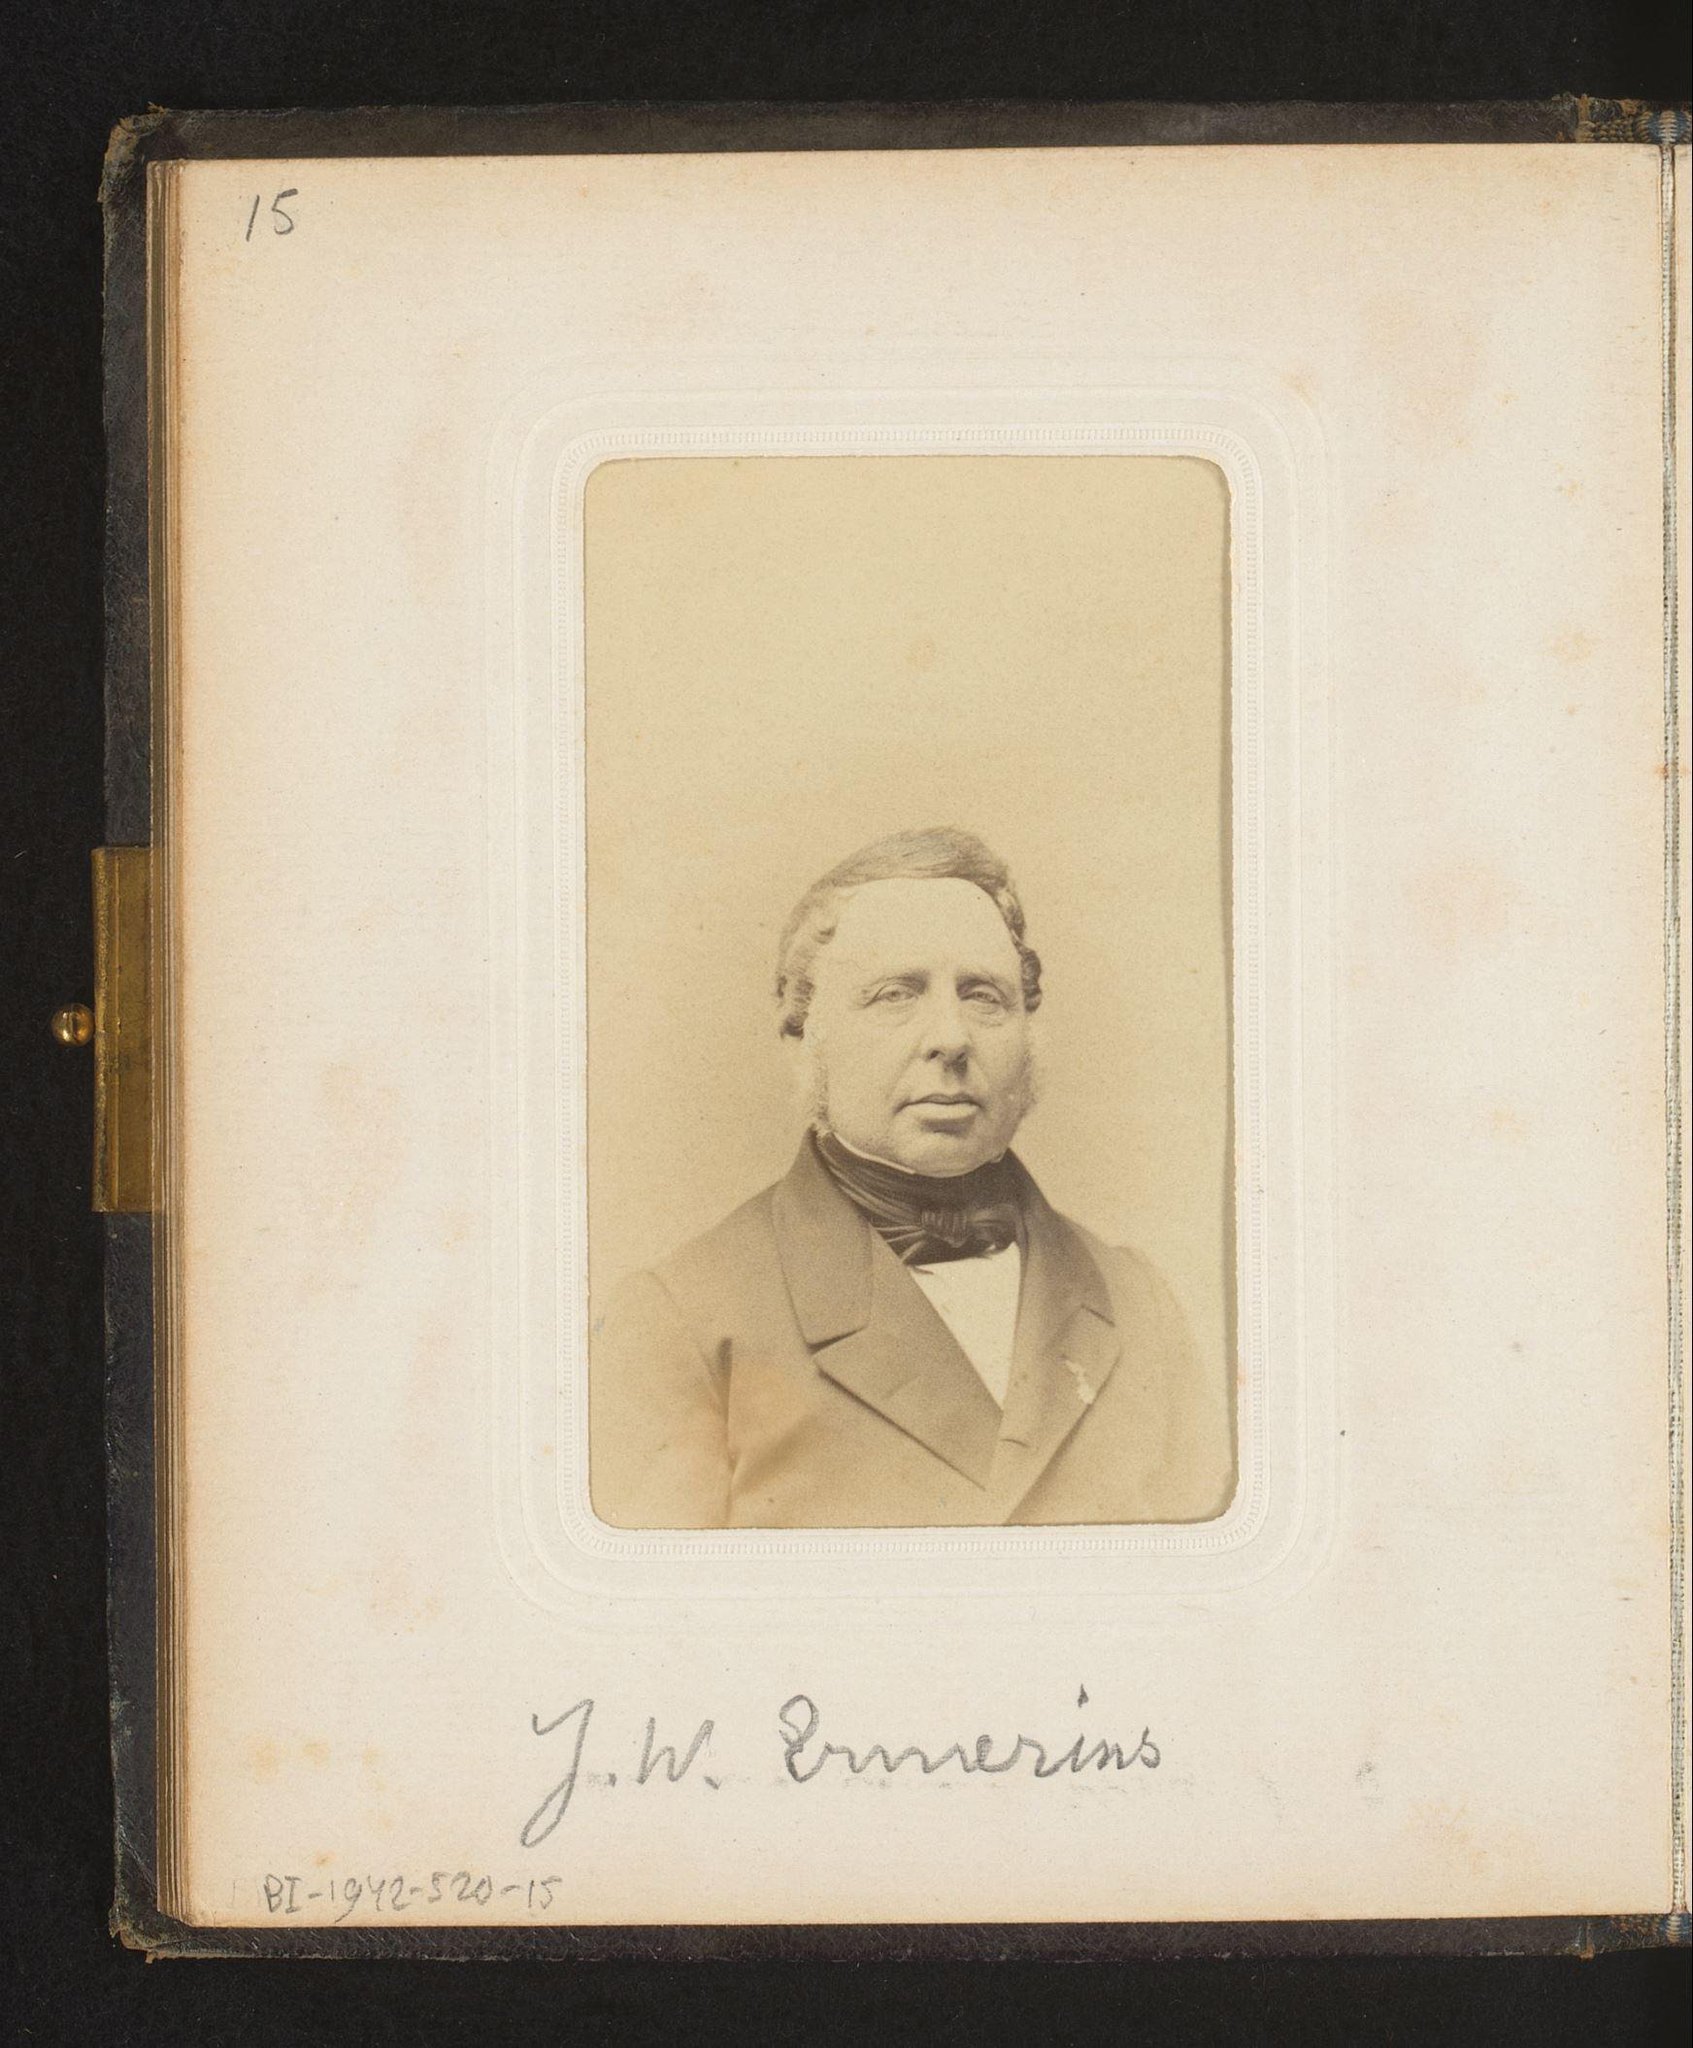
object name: album leaf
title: Portret van Jan Willem Ermerins, hoogleraar in de faculteit Wis- en Natuurkunde aan de universiteit van Groningen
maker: johannes hinderikus egenberger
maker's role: draughtsman, print maker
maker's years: 1822-1897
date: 1864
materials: cardboard, paper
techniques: albumen print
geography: groningen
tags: physicist, historical persons, professor, groningen (province)